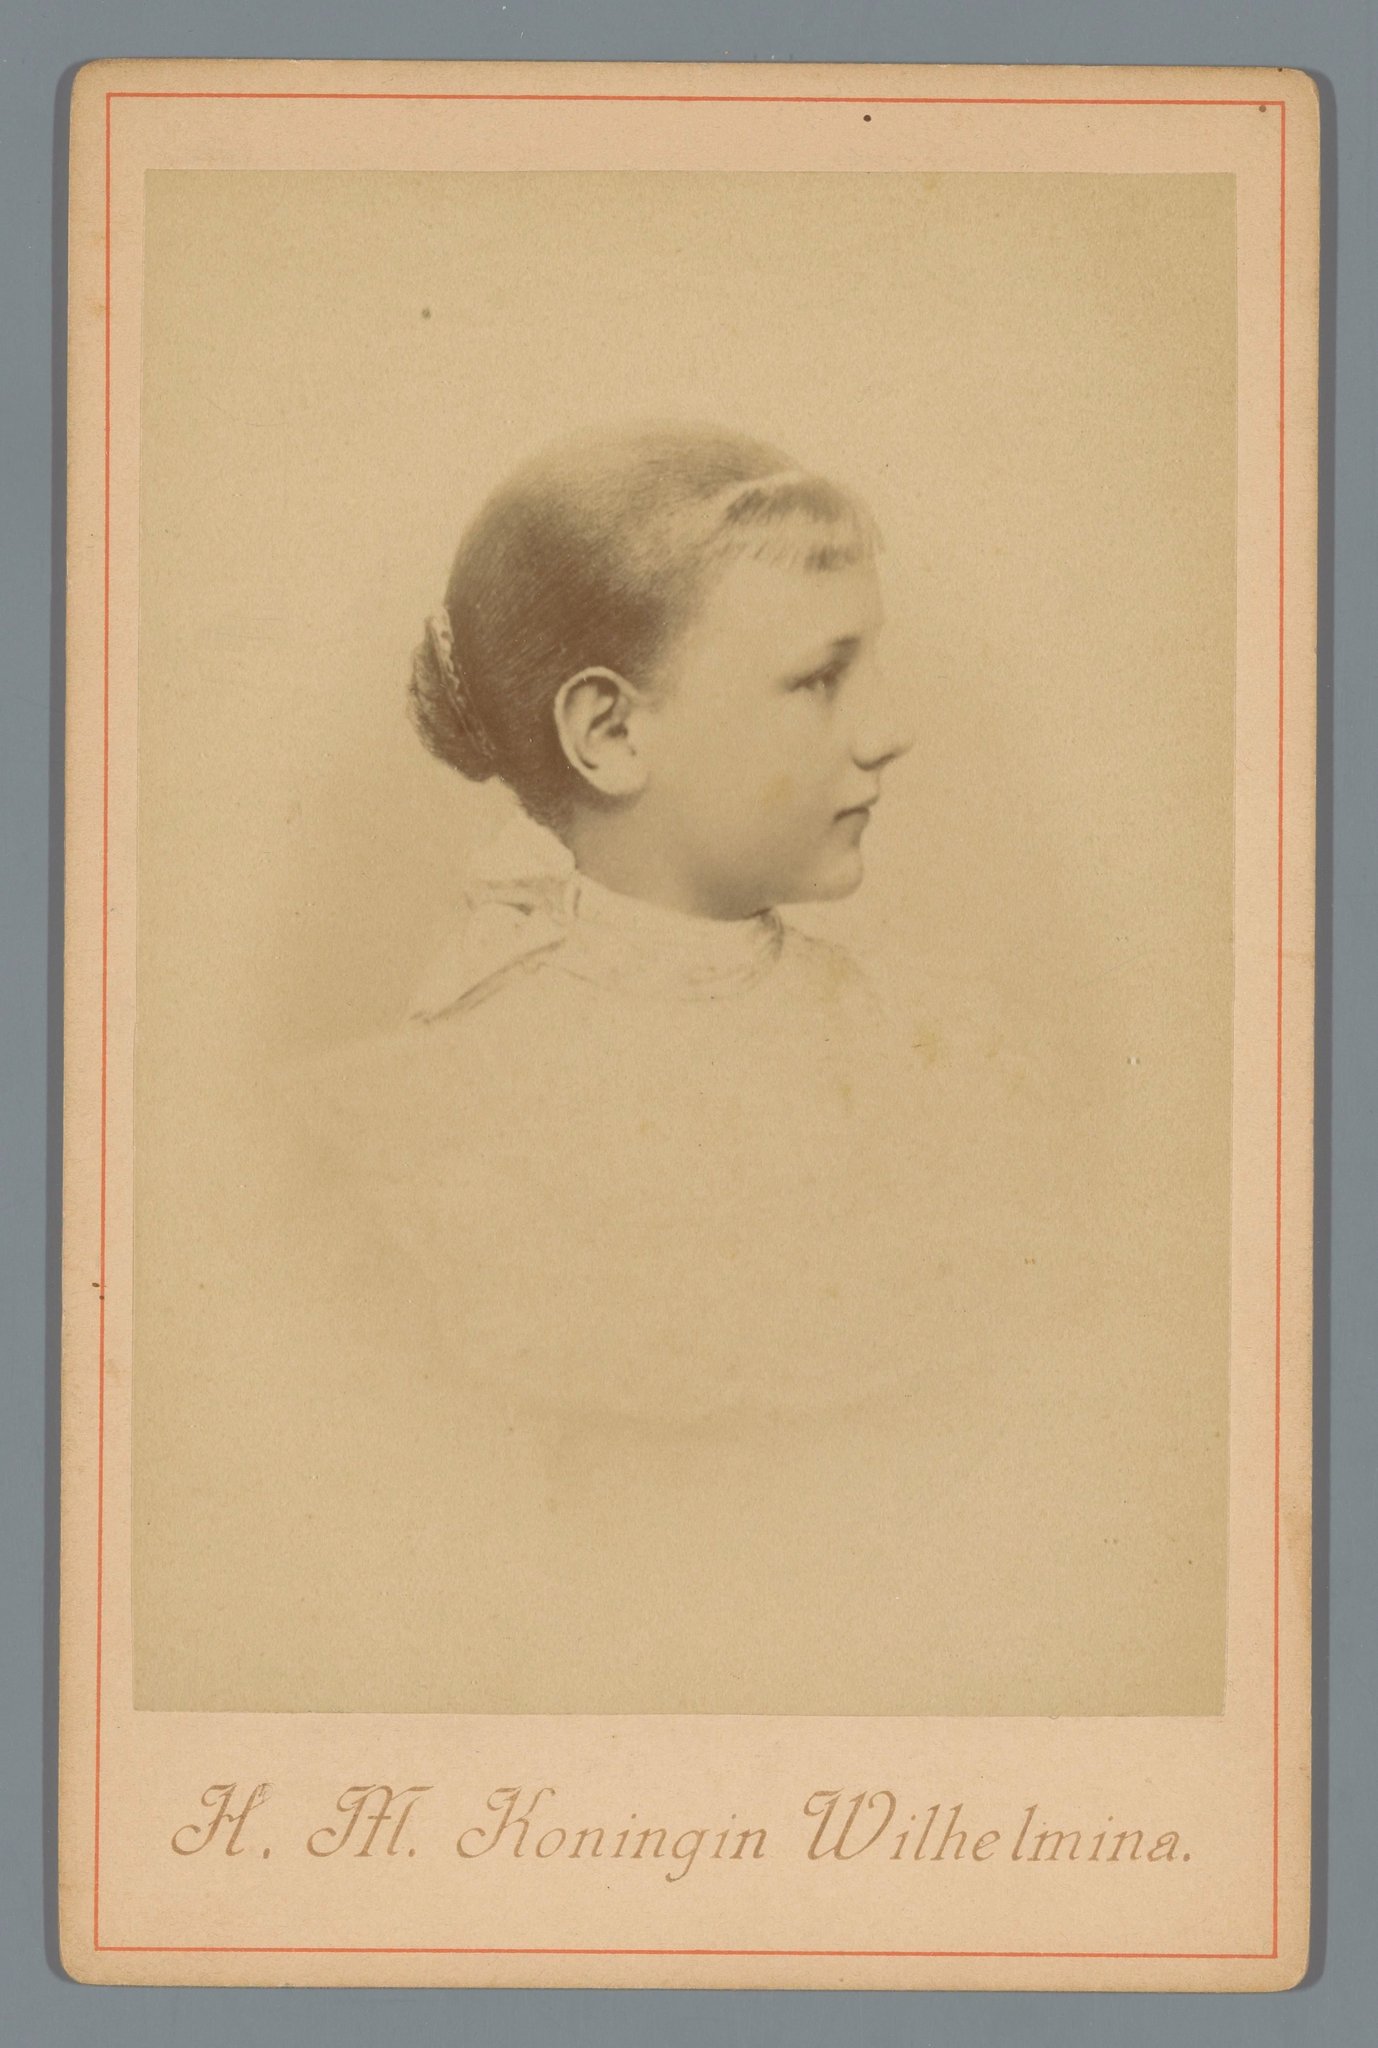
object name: cabinet photograph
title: H.M. koningin Wilhelmina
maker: Anonymous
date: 1896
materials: cardboard, paper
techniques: albumen print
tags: the hague, print maker, wilhelmina of the netherlands, historical persons, queen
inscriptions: inscription: ‘Wilhelmina/ 1896’